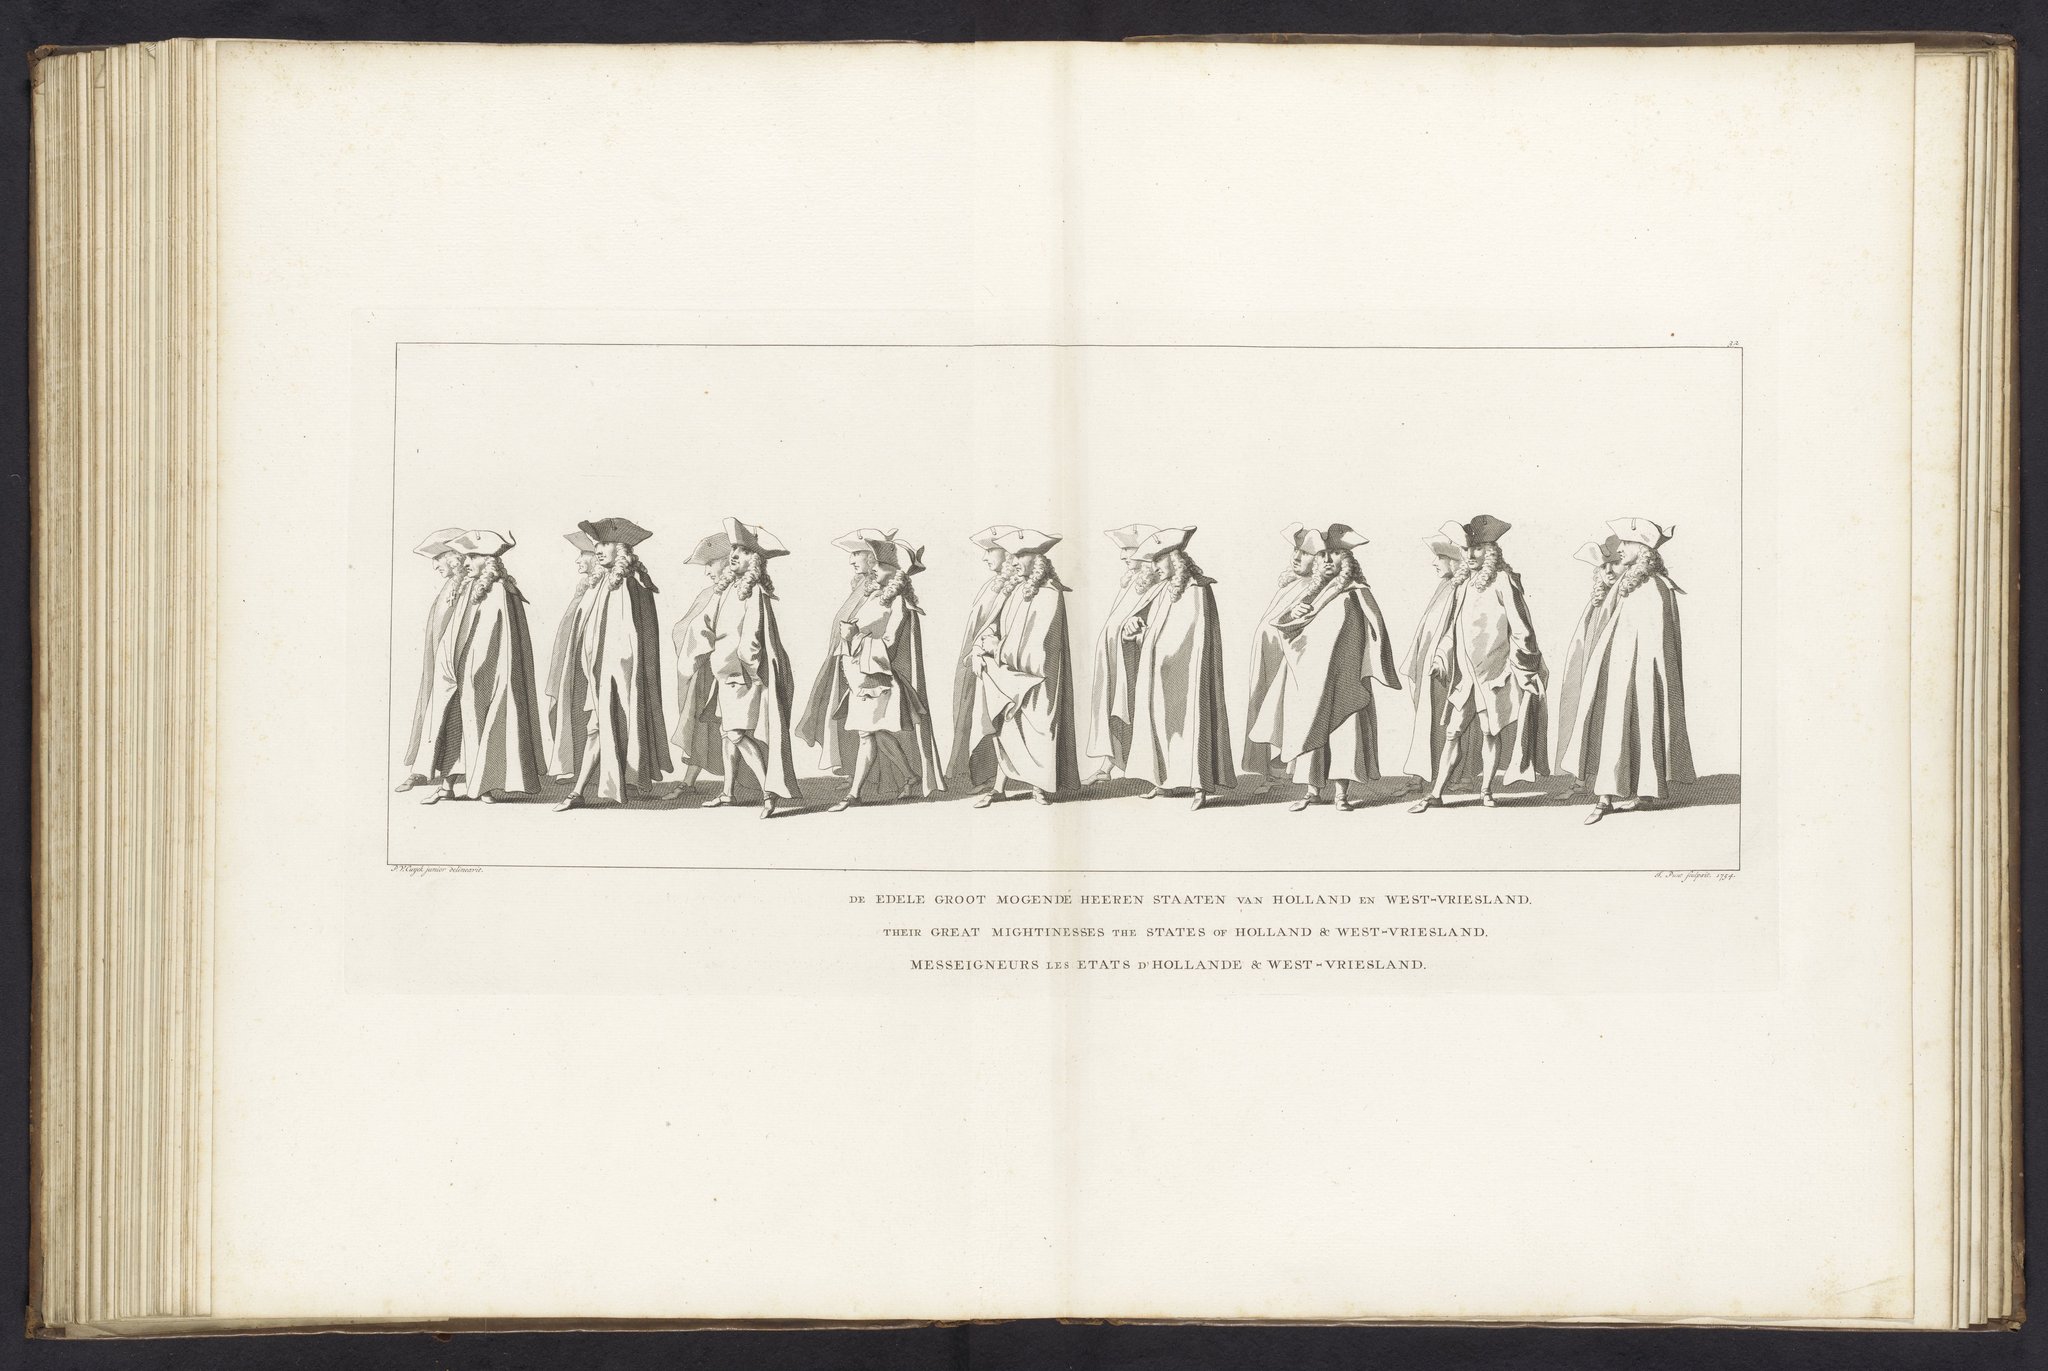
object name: print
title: De Edele Groot Mogende Heeren Staaten van Holland en West-Vriesland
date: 1754-1755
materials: paper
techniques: engraving, etching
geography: northern netherlands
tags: willem iv (prins van oranje-nassau), cortege, funeral procession, lower house, parliament, chamber, delft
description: Leden van de Staten van Holland en West-Friesland. In de marge het onderschrift in Nederlands, Frans en Engels. Onderdeel van een serie van 41 platen van de begrafenisstoet van stadhouder Willem IV te Delft op 4 februari 1752. Genummerd rechtsboven: 32. In de gebonden uitgave van 1755.